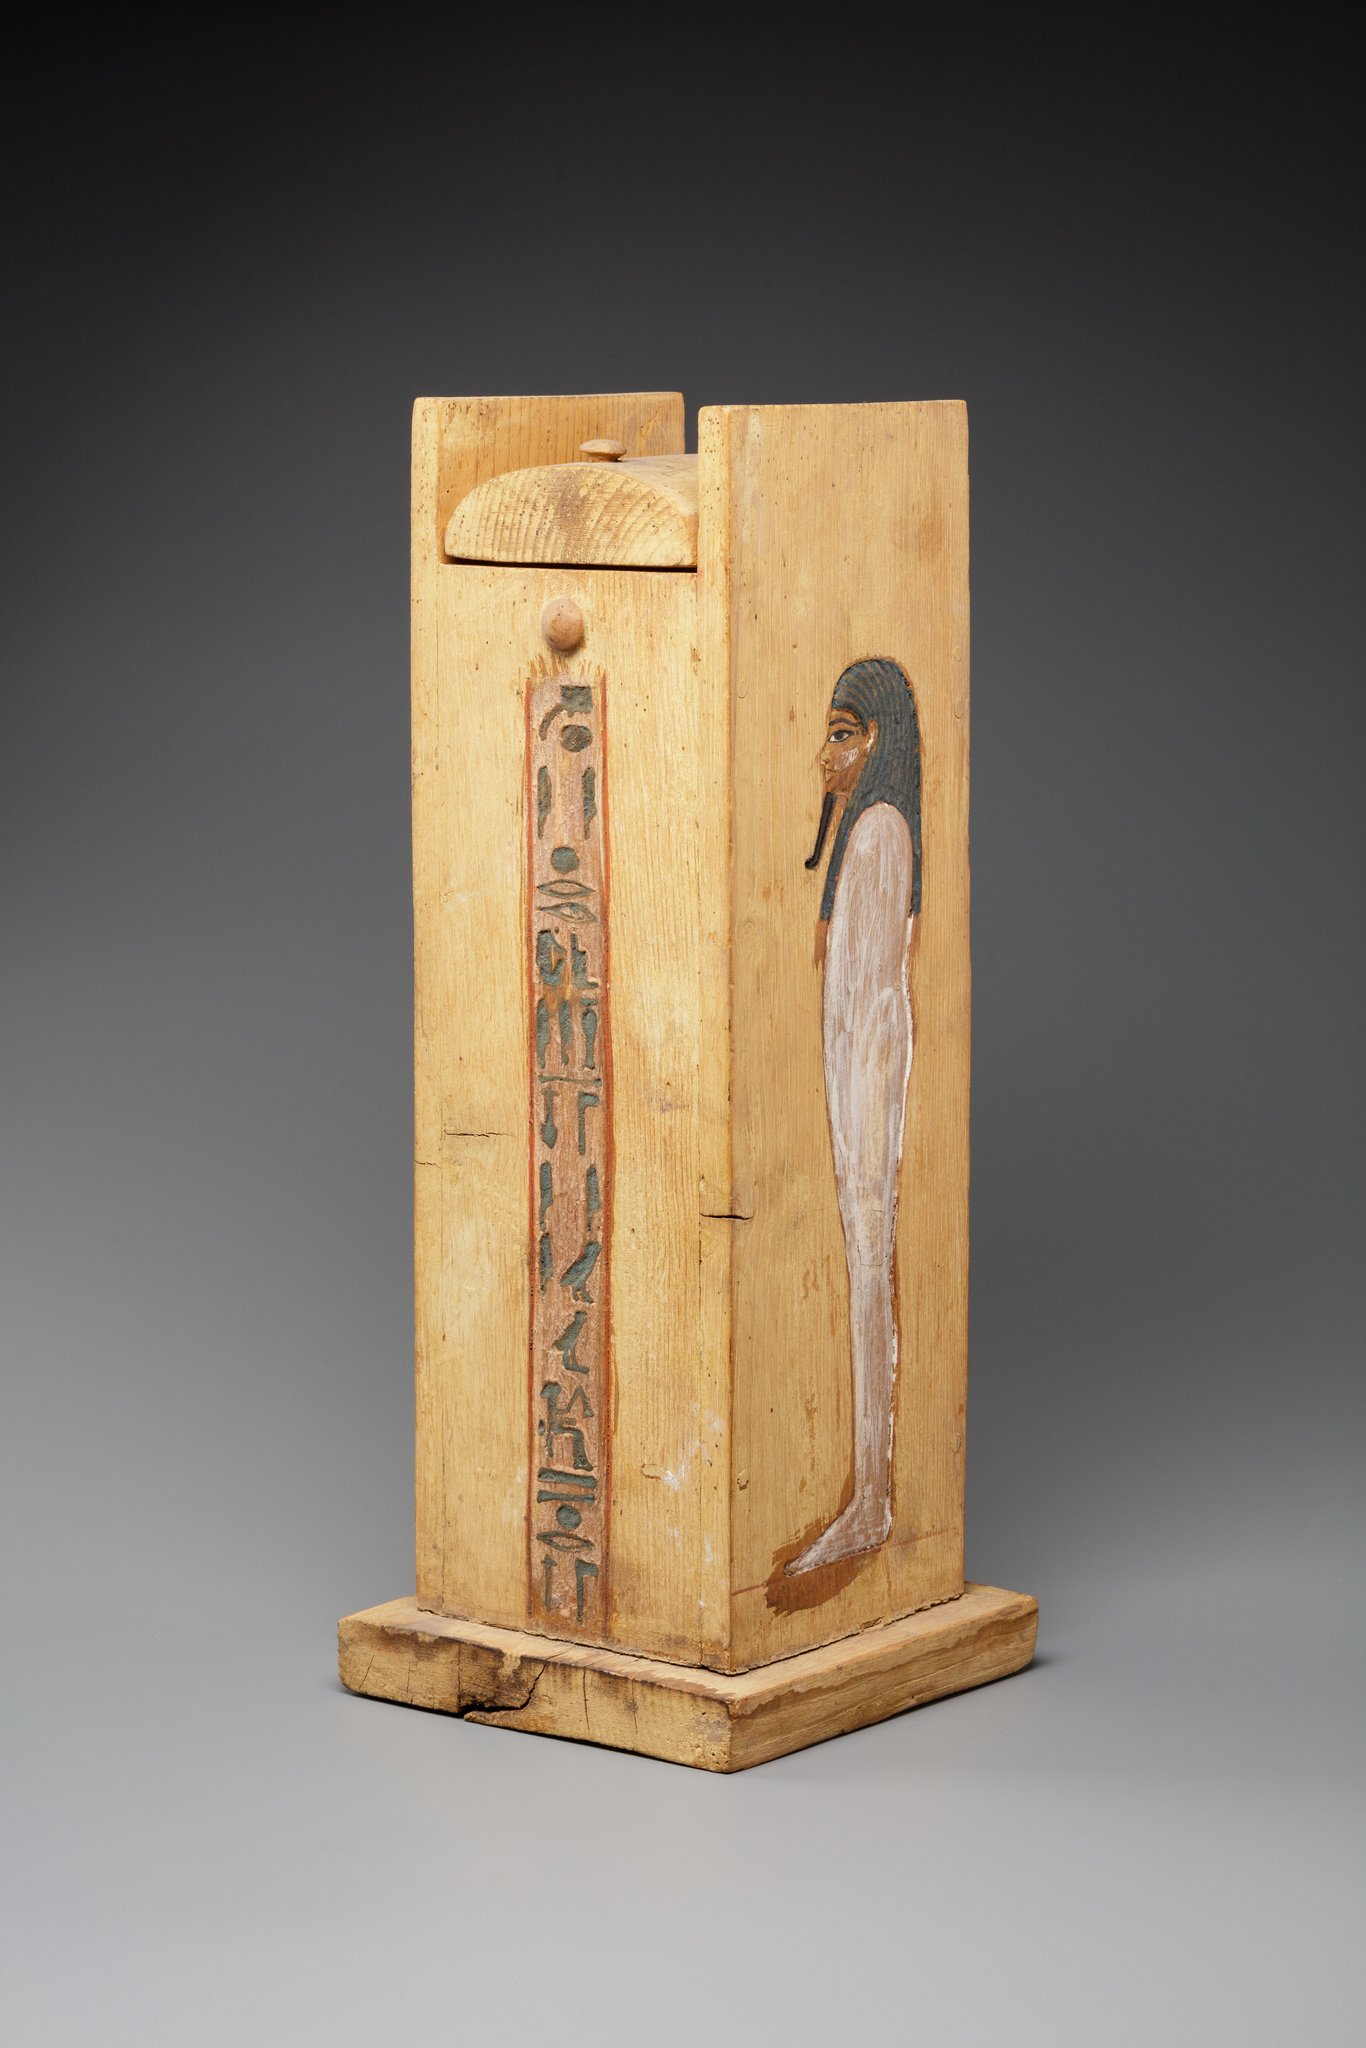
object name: shabti box, yuya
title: Shabti Box of Yuya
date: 1390-1352 BCE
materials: wood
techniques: painting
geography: egypt